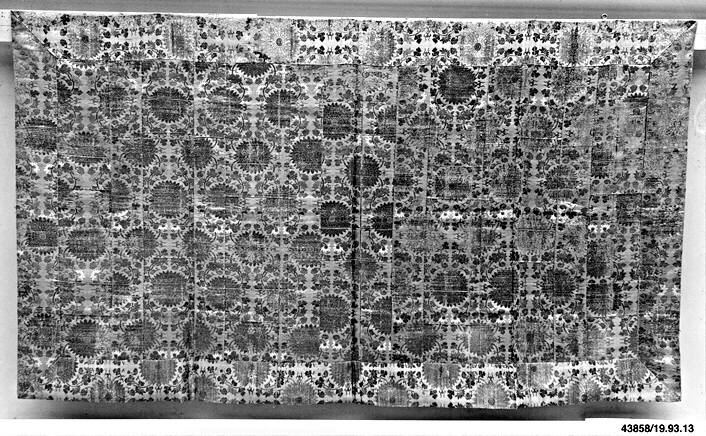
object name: robe, priest's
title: Priest's Robe (Shichijō)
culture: japanese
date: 1648-1652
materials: metal thread, silk